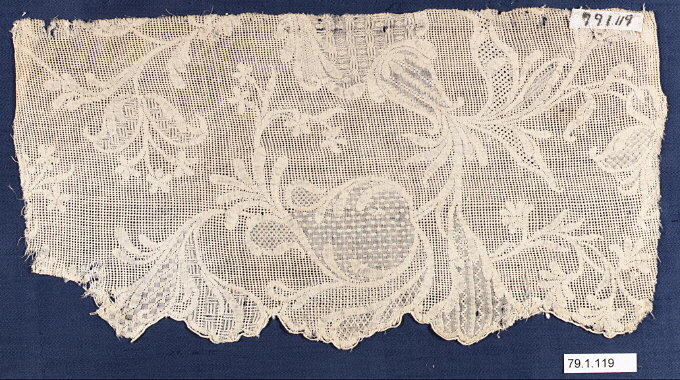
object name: fragment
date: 1701-1800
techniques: embroidery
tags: flowers,leaves